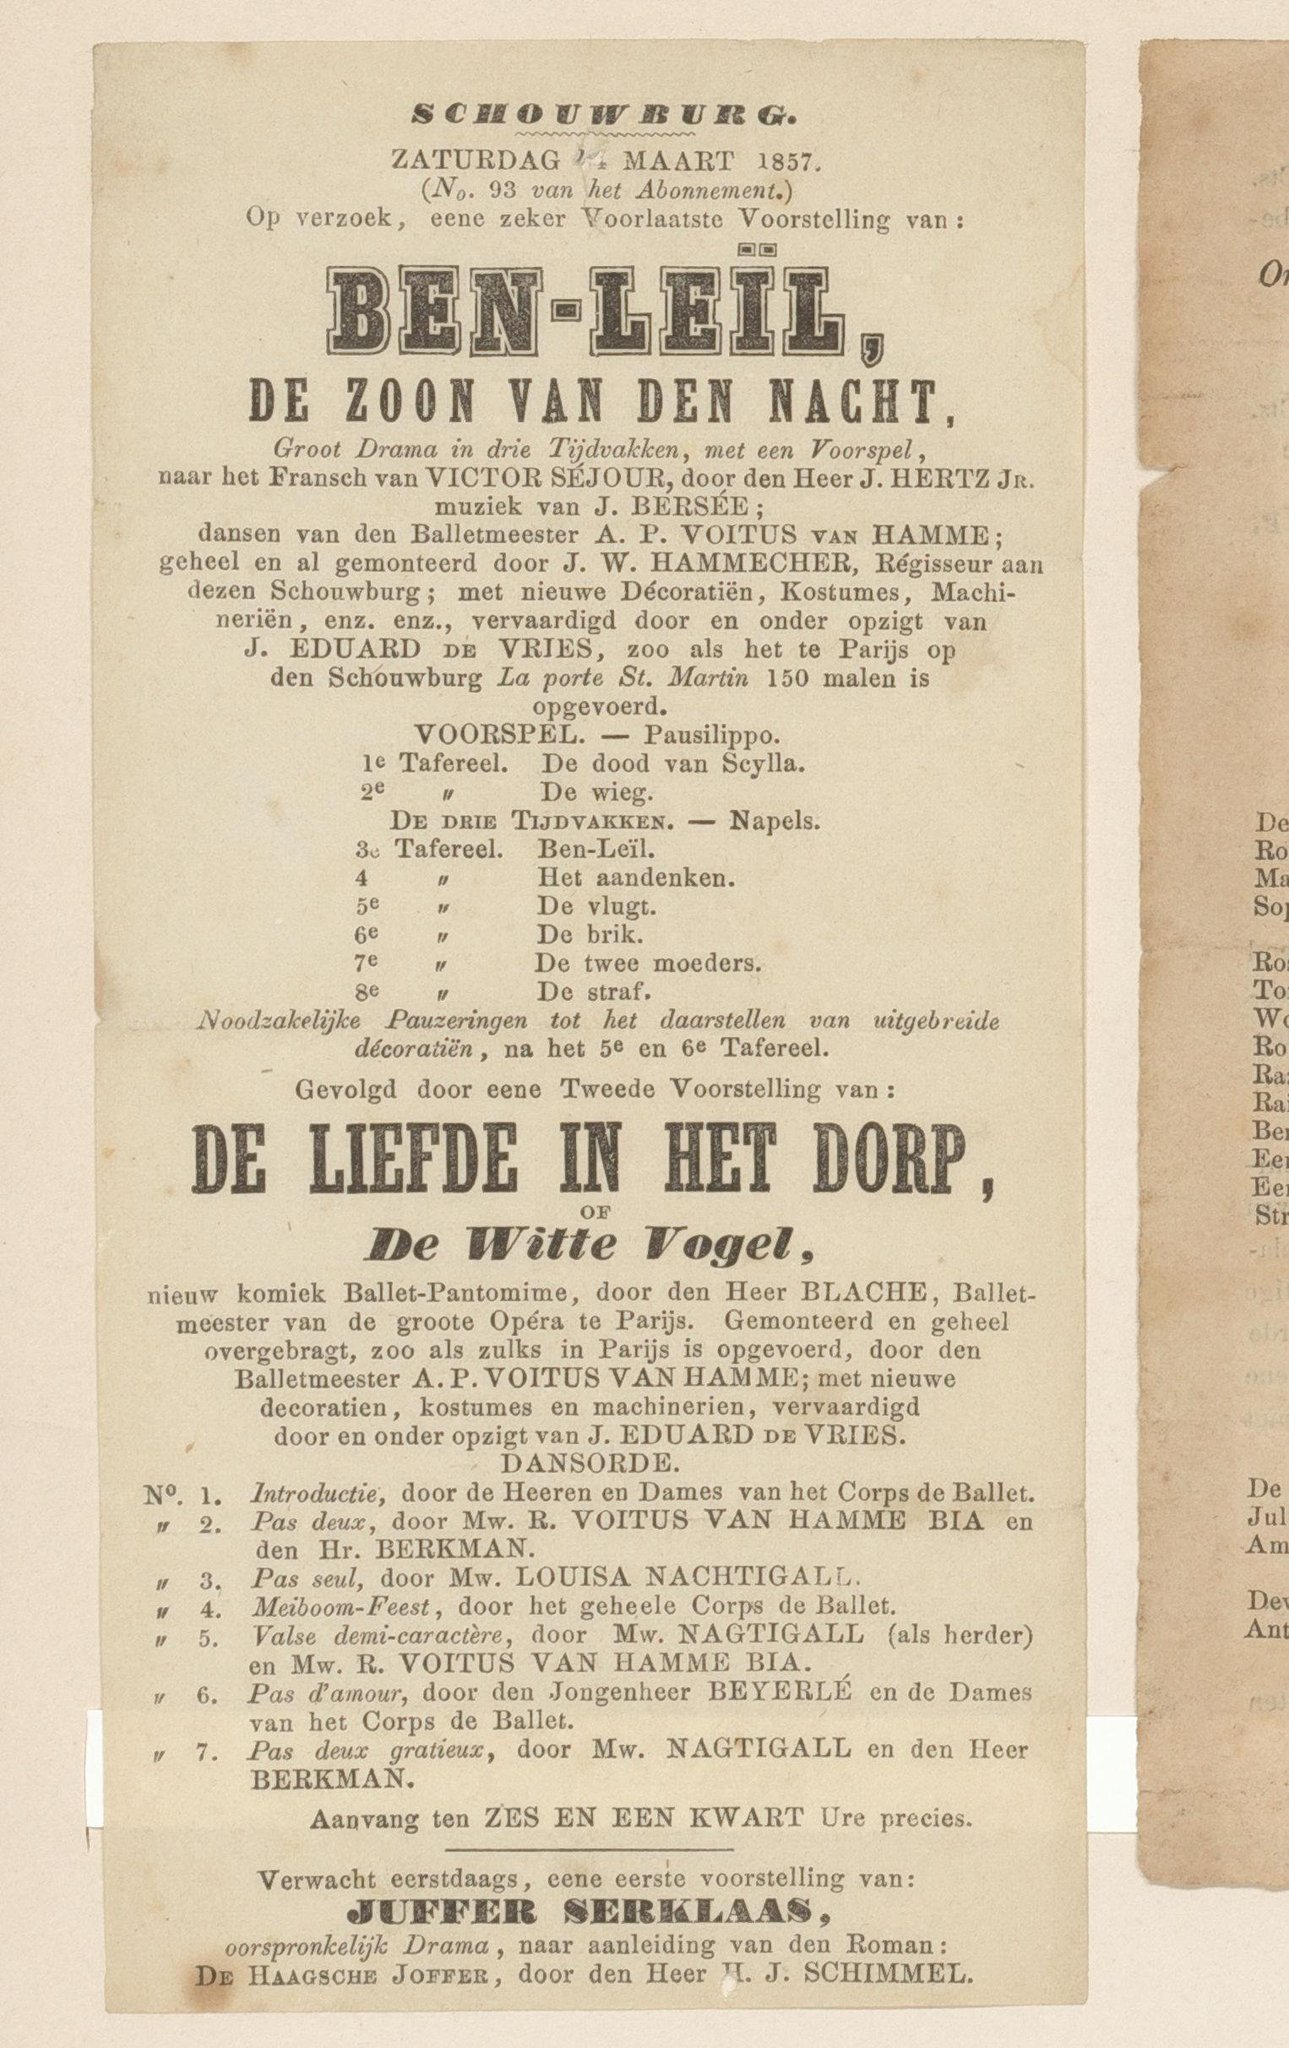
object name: text sheet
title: Aankondiging van de balletvoorstelling Ben-Leil, de zoon van den Nacht, 1857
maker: Anonymous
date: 1857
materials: paper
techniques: letterpress printing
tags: theatre, theatrical performance, art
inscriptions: collector's mark: Lugt 1641, stamp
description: Aankondiging van de balletvoorstellingen Ben-Leil, de zoon van den Nacht en De Liefde in het Dorp of De Witte Vogel. De voorstelling vindt plaats in de schouwburg in maart 1857. Onderwerpsrubrieken binnen de Atlas Zeden en Gewoonten: Tooneel, Toneelprogramma’s.